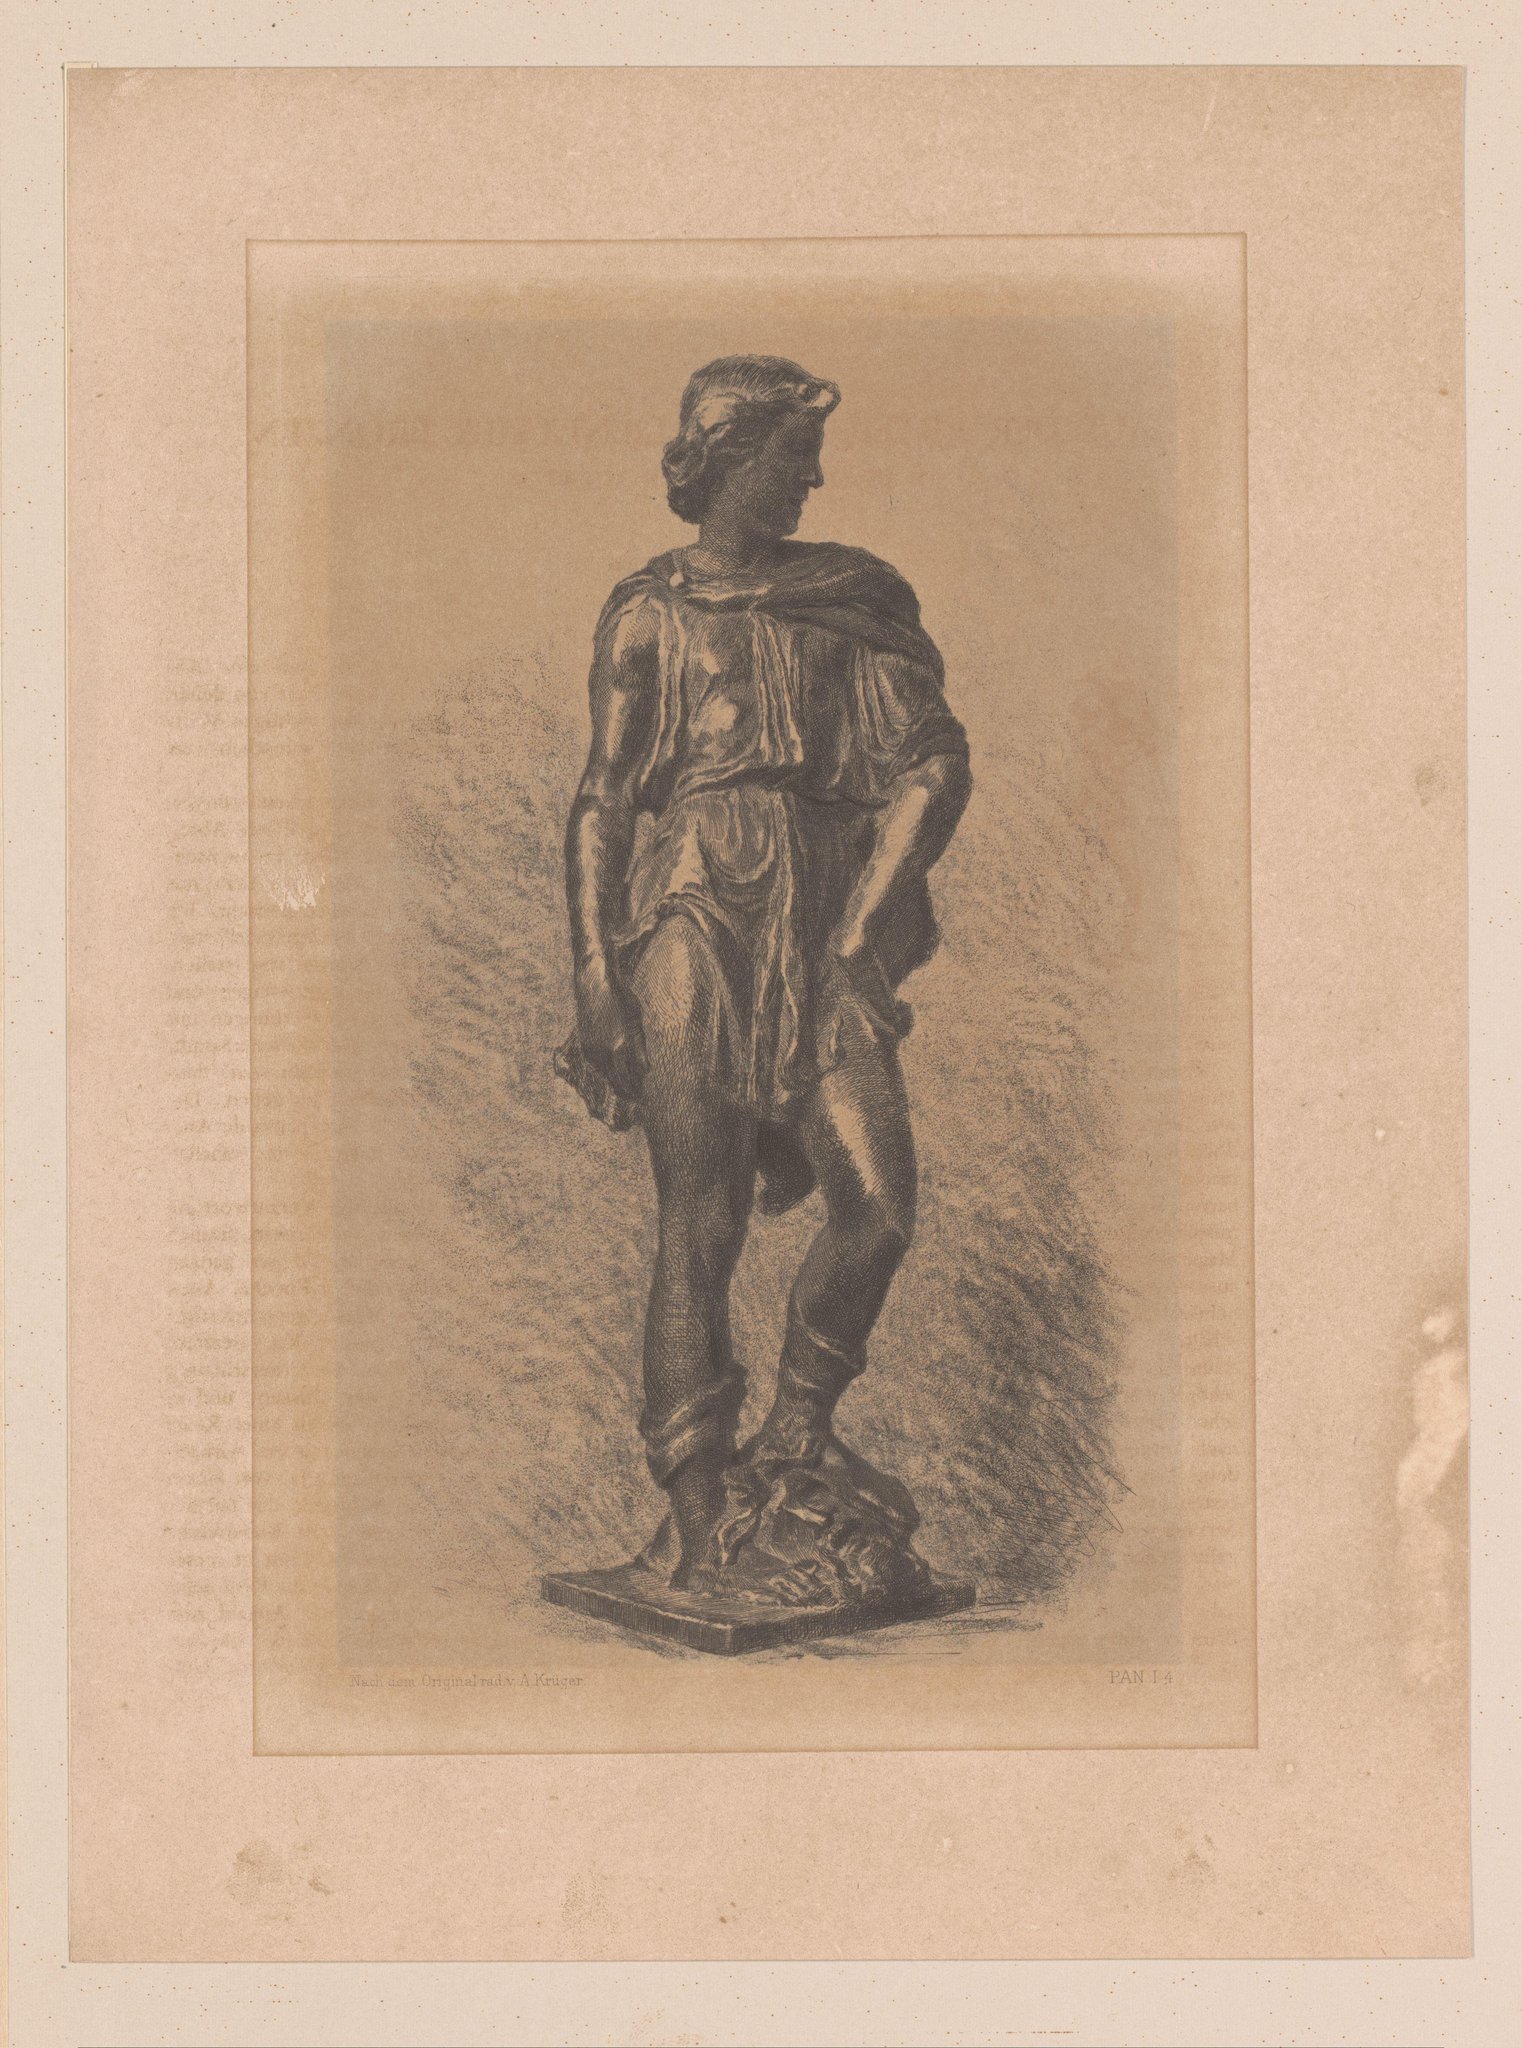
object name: print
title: Bronzen beeld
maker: albert krüger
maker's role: painter, print maker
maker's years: 1858-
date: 1896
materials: paper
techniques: etching, intaglio, soft ground etching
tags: sculpture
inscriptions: collector's mark: Lugt 2228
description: Prent is uitgeven in het tijdschrift 'Pan', 1895-1896, deel 4.